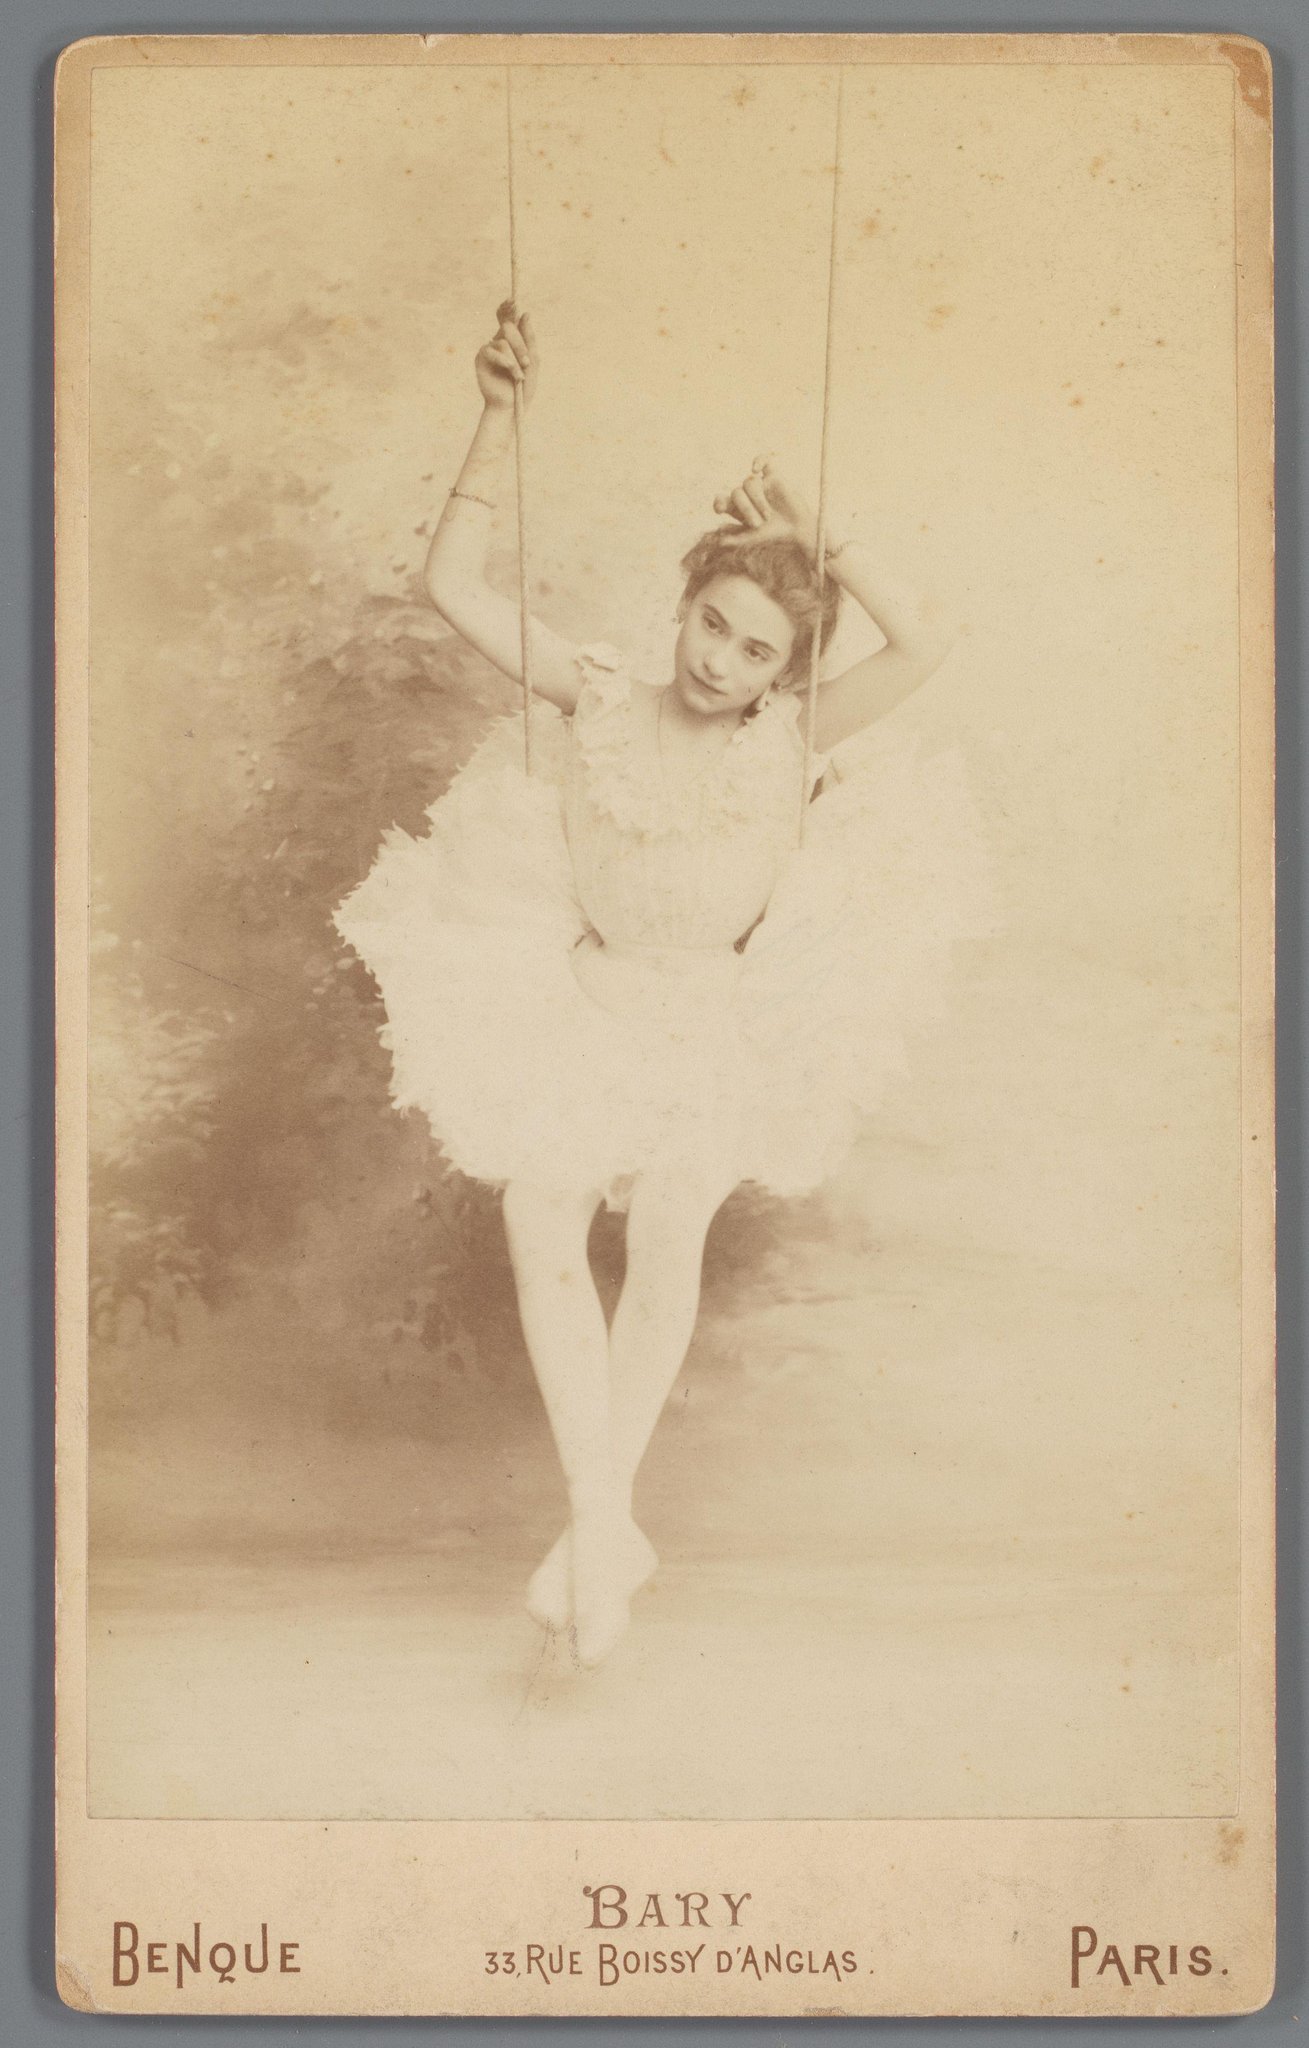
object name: photograph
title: Portret van een onbekend meisje, aangeduid als Constance, op een schommel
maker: bary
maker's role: fotograaf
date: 1803-1899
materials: cardboard, paper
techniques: albumen print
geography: paris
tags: girl (child between toddler and youth), anonymous historical person portrayed, swing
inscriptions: inscription: ‘D ma soeur [...]/ Constance le Mars 1899’, inscription: ‘Paris Portrait/ BENQUE/ 33, Rue Boissy- d'Anglas (Hôtel Particulier)/ EXPOSITION. 5, RUE ROYALE/ PARIS/ Pastels et Peinture/ REPRODUCTIONS AGRANDISSEMENTS/ Ateliers à Mesnif-le-Roy/ POUR LA FABRICATION DES/ Emaux & Vitraux en Noir et en Couleur/ Photographies à la Lumiere Electrique’, address: ‘BENQUE/ BARY/ 33, RUE BOISSY D'ANGLAS./ PARIS.’